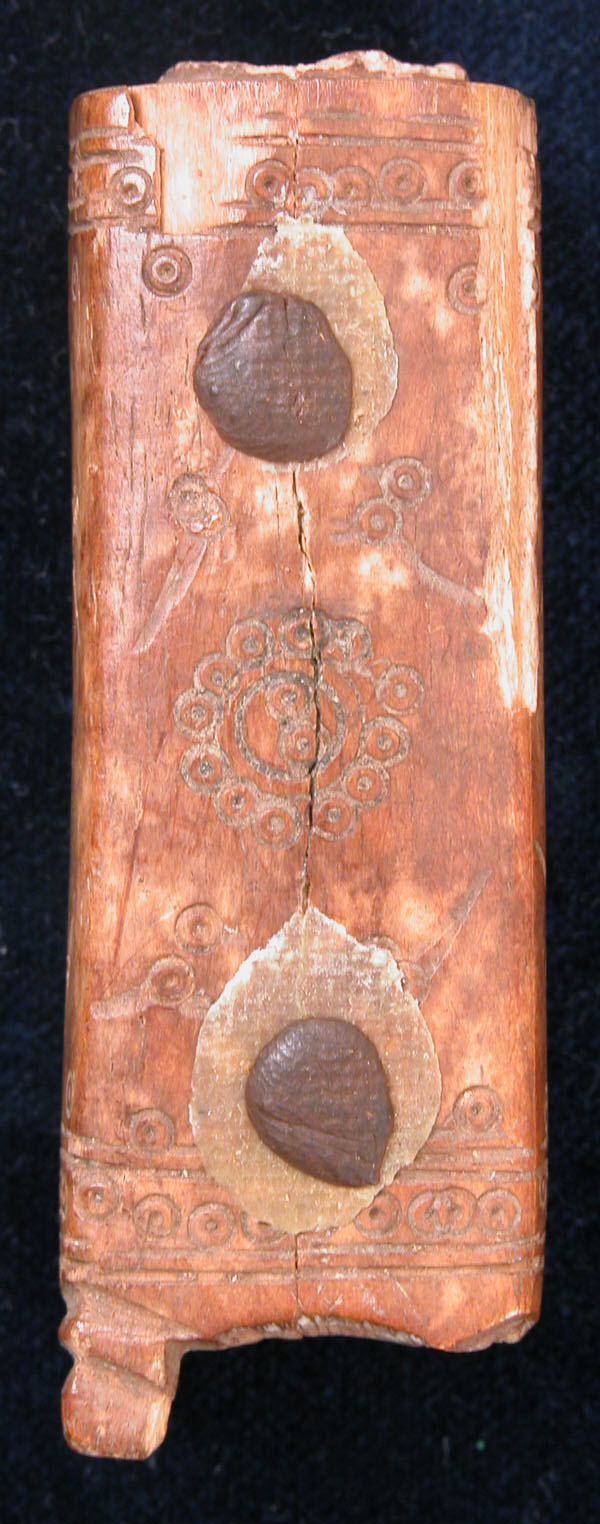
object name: fragment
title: Bone Fragment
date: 401-600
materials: bone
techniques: incising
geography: egypt